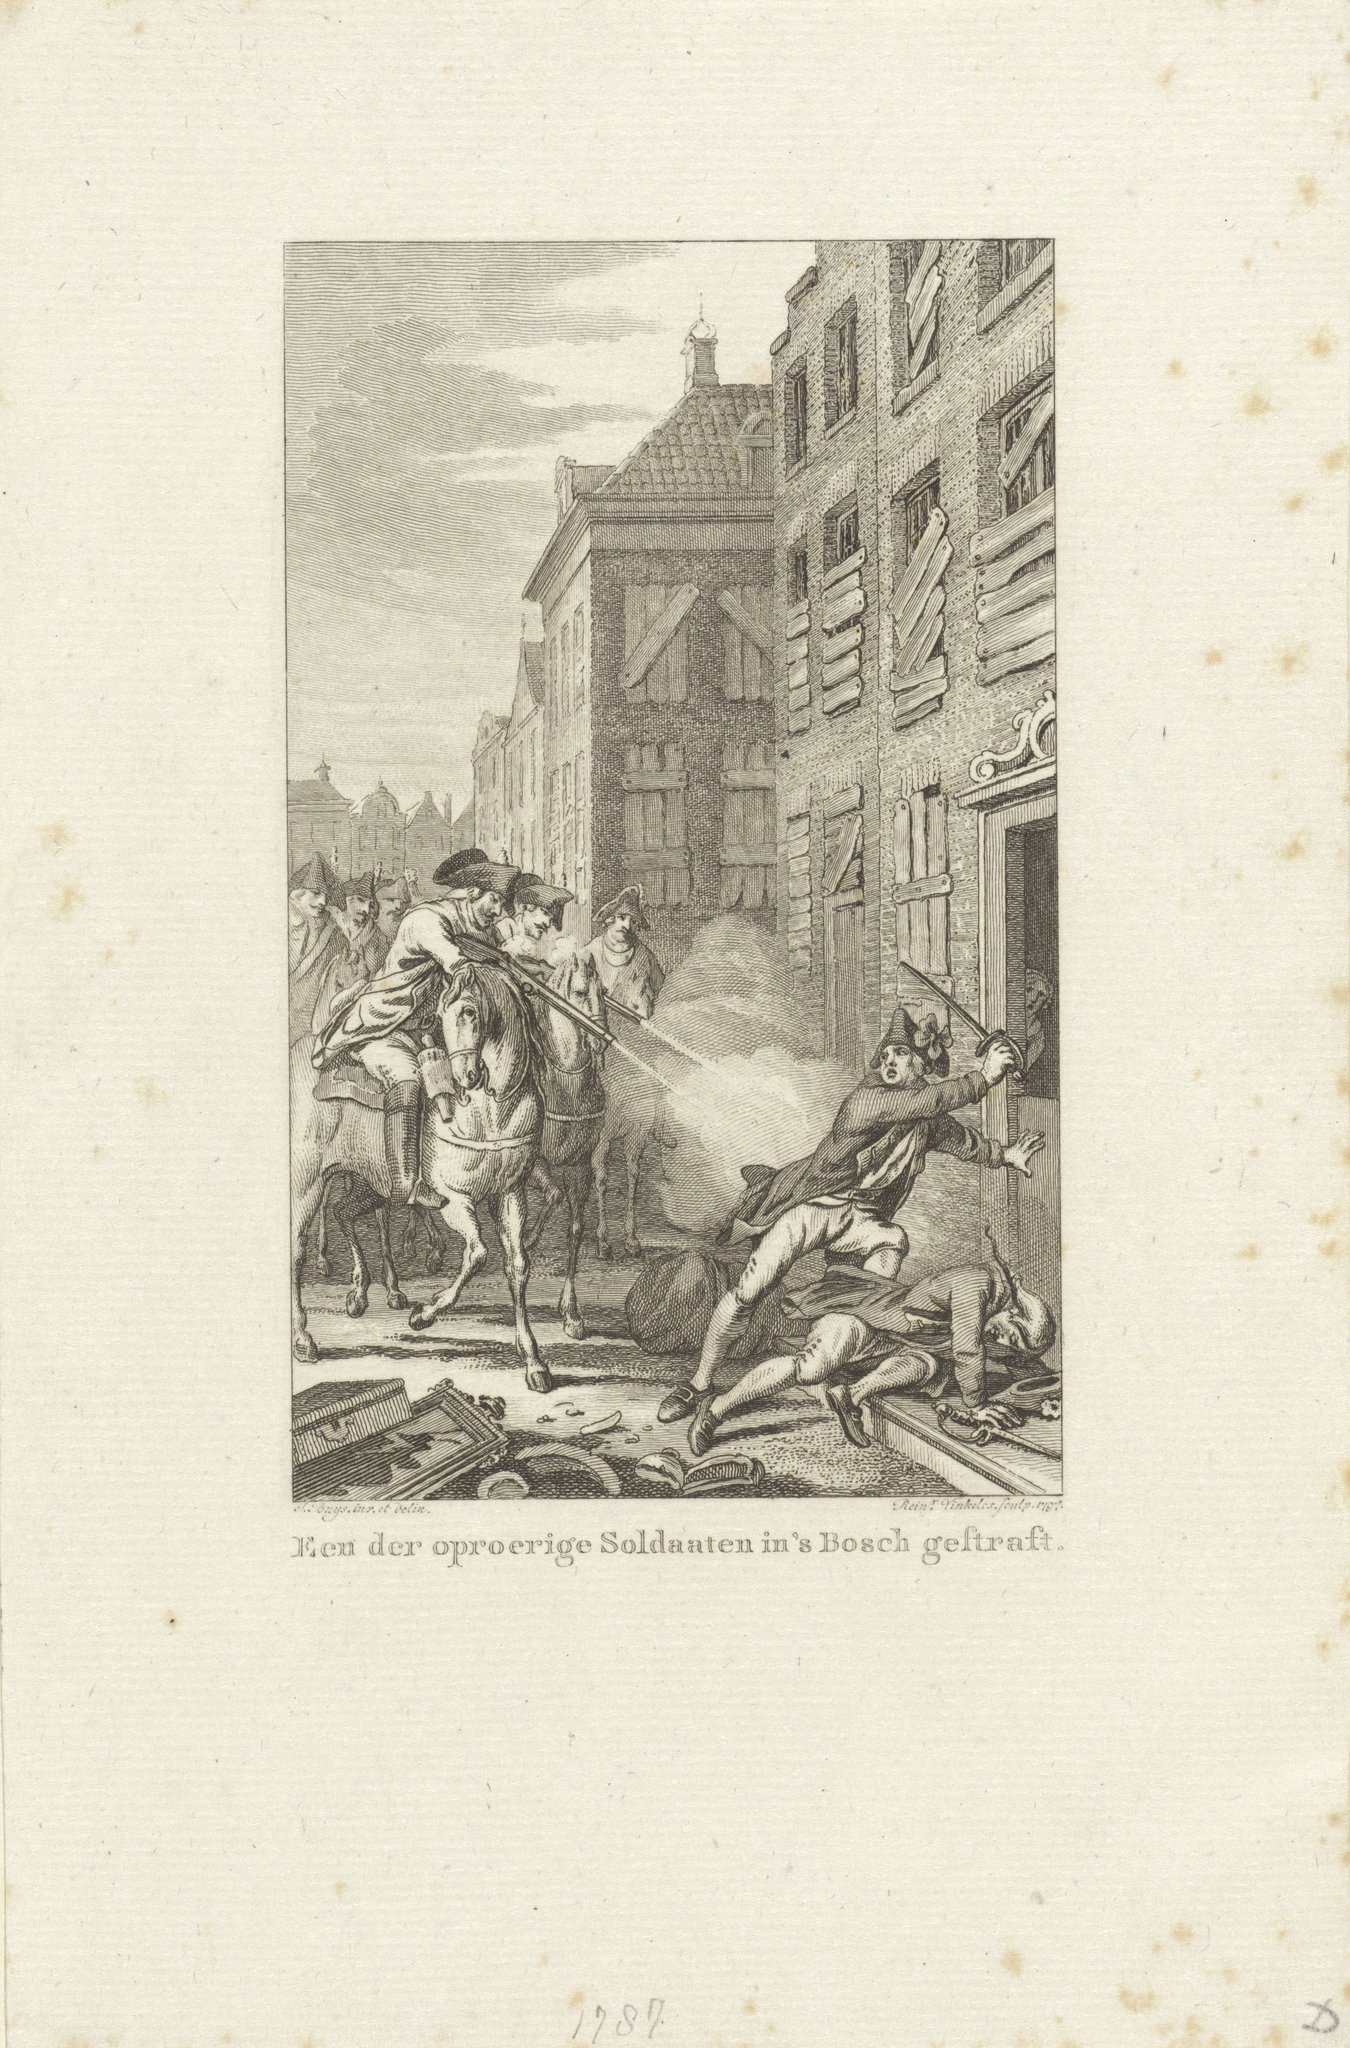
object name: book illustration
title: Bestraffing van twee oproerige soldaten in Den Bosch, 1787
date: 1797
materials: paper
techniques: engraving, etching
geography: amsterdam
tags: mutiny, rebellion ~ military discipline, den bosch, patriots (1780-1795)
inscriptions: date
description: Gebruikt als illustratie in: P.A. Loosjes. Vaderlandsche historie, vervattende de geschiedenissen, der Vereenigde Nederlanden (...). Ten onmiddelyken vervolge van Wagenaar's Vaderlandsche historie. Amsterdam: Johannes Allart, dl. 19.